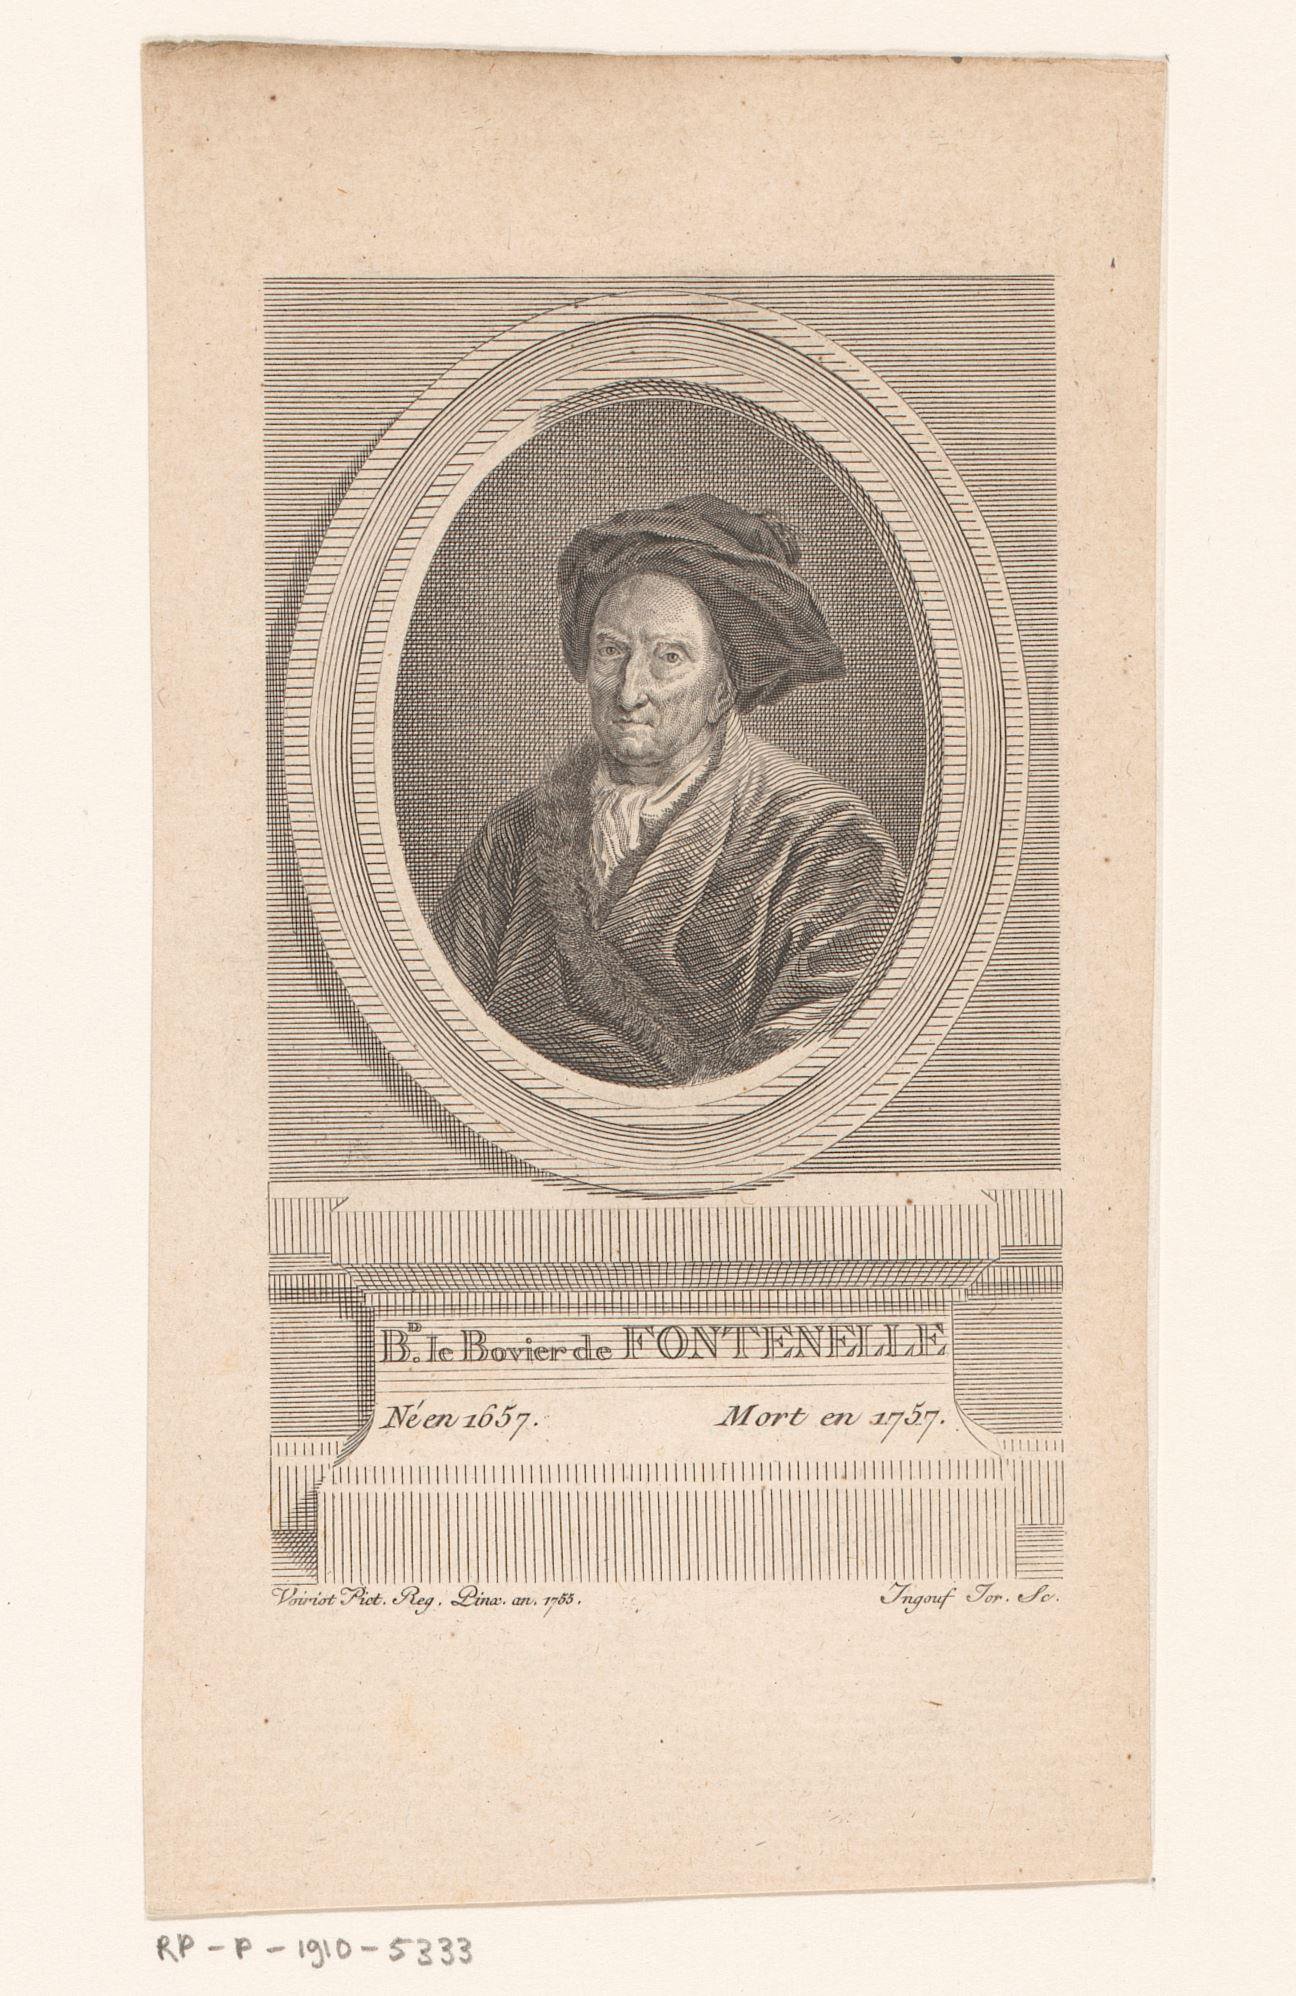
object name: print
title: Portret van Bernard Le Bovier de Fontenelle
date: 1778-1787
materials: paper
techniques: engraving, etching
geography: france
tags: paris, scholar, philosopher, historical persons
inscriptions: collector's mark: Lugt 2228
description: Prent uit: Annales poétiques, ou Almanach des Muses. Parijs: Delalain, 1778-1787, dl. 32.